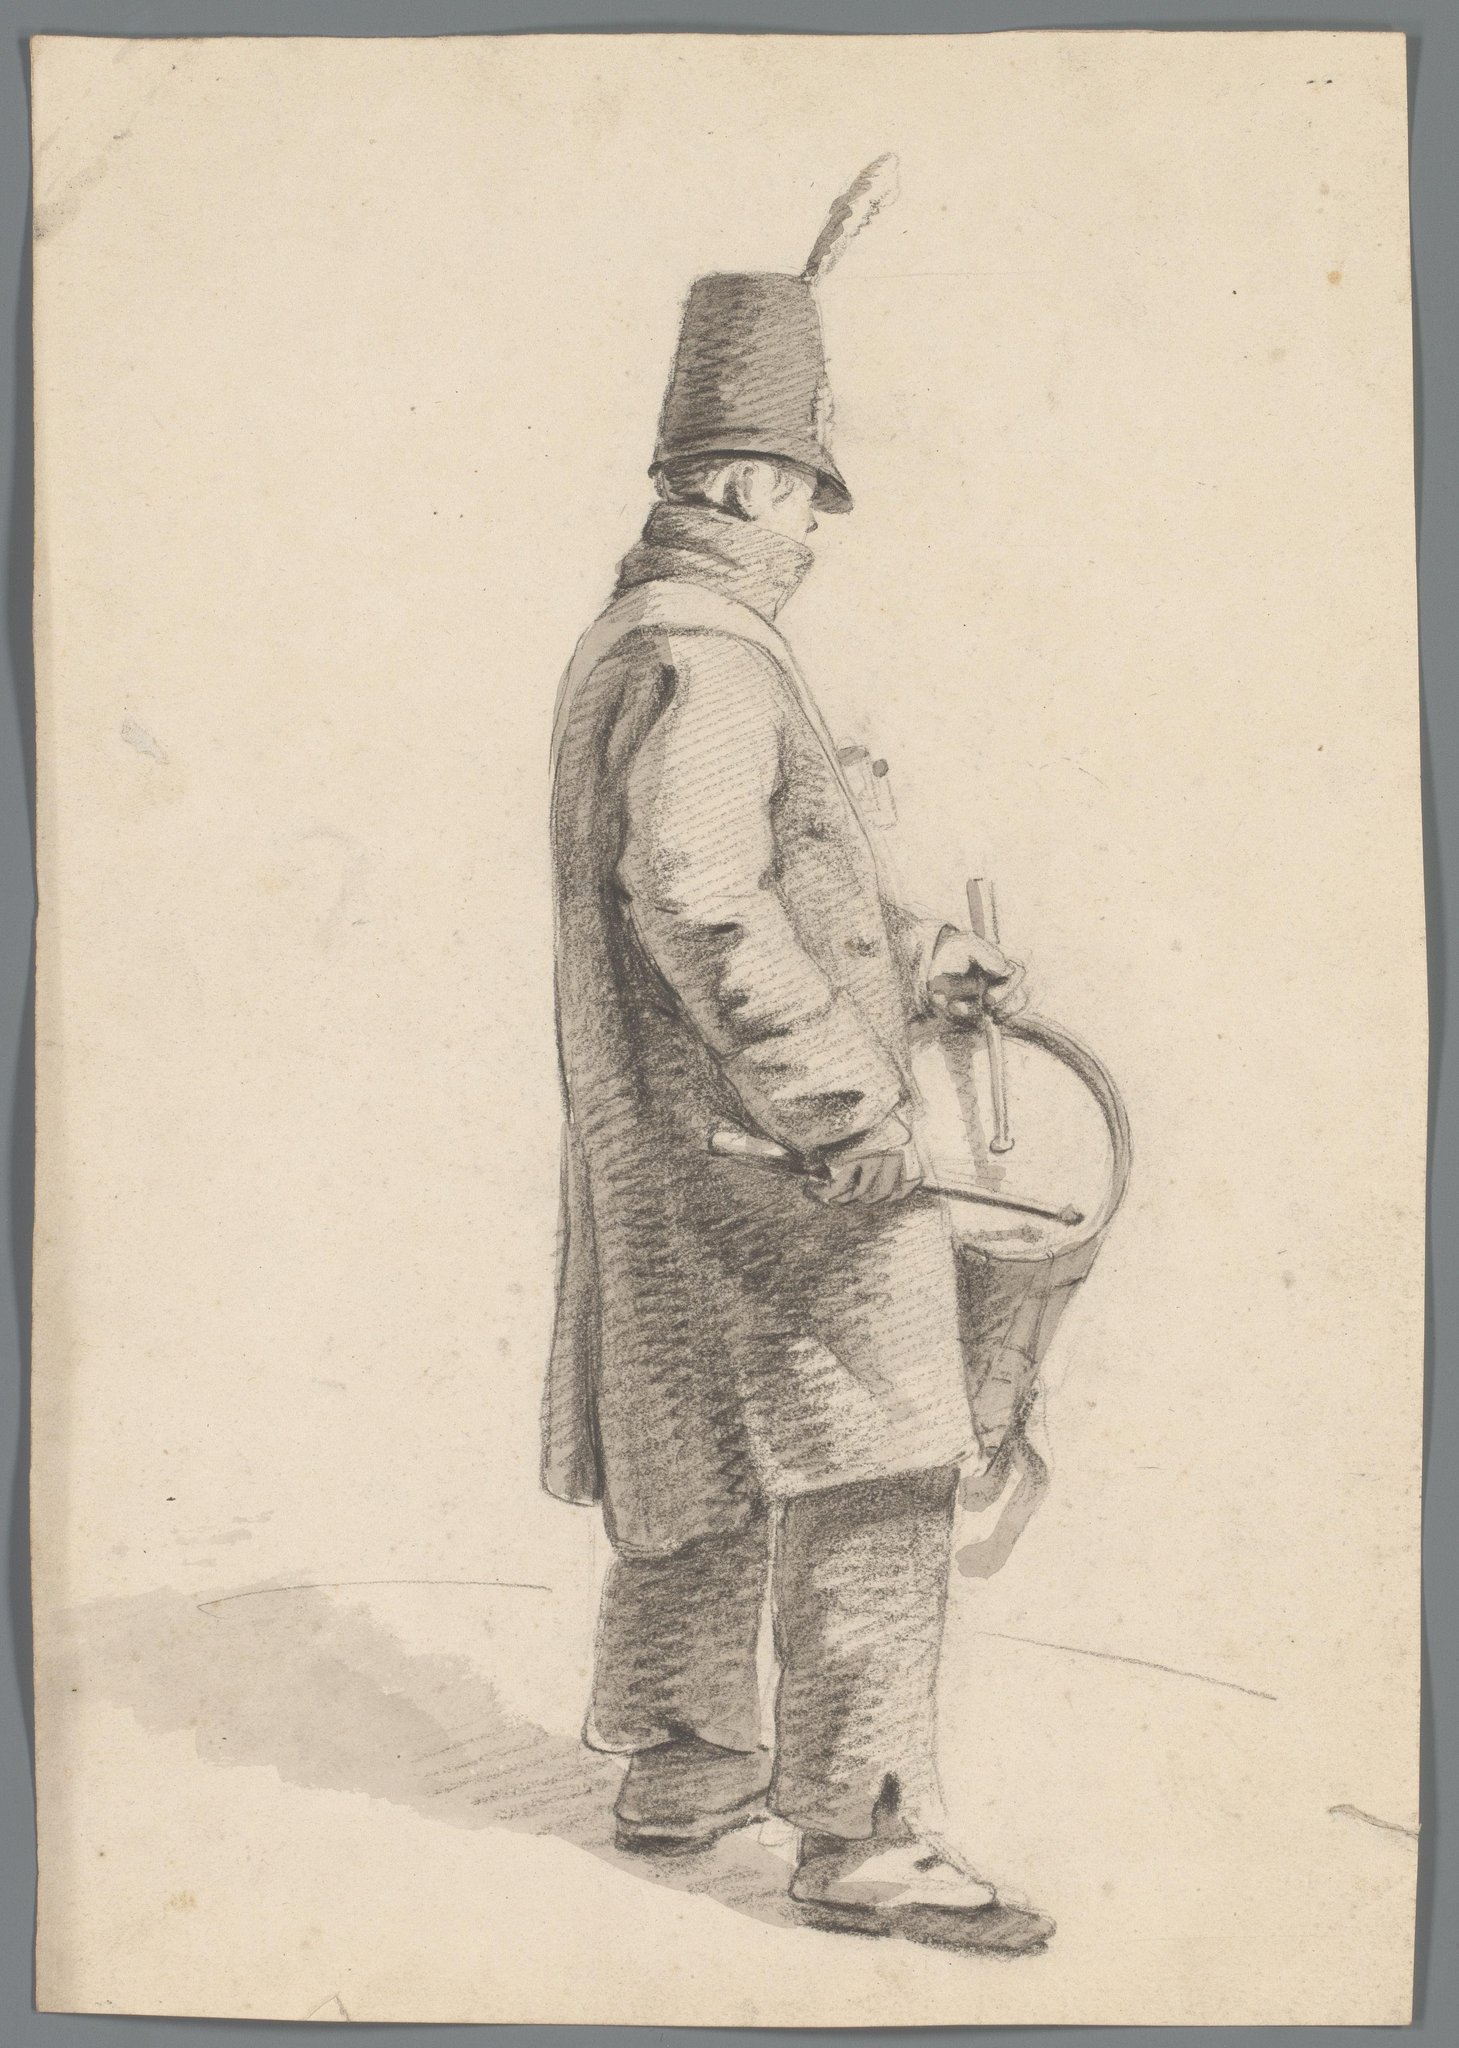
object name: drawing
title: Man met trommel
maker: Anonymous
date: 1820-1830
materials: chalk, paper, watercolor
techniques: brush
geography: the hague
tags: adult man, drum (musical instrument)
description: Tekeningen waarschijnlijk ontstaan bij het Haagse kunstgenootschap ‘Tot Nut der Tekenkunst’, waar twee keer per week tekenavonden werden georganiseerd met geklede modellen.